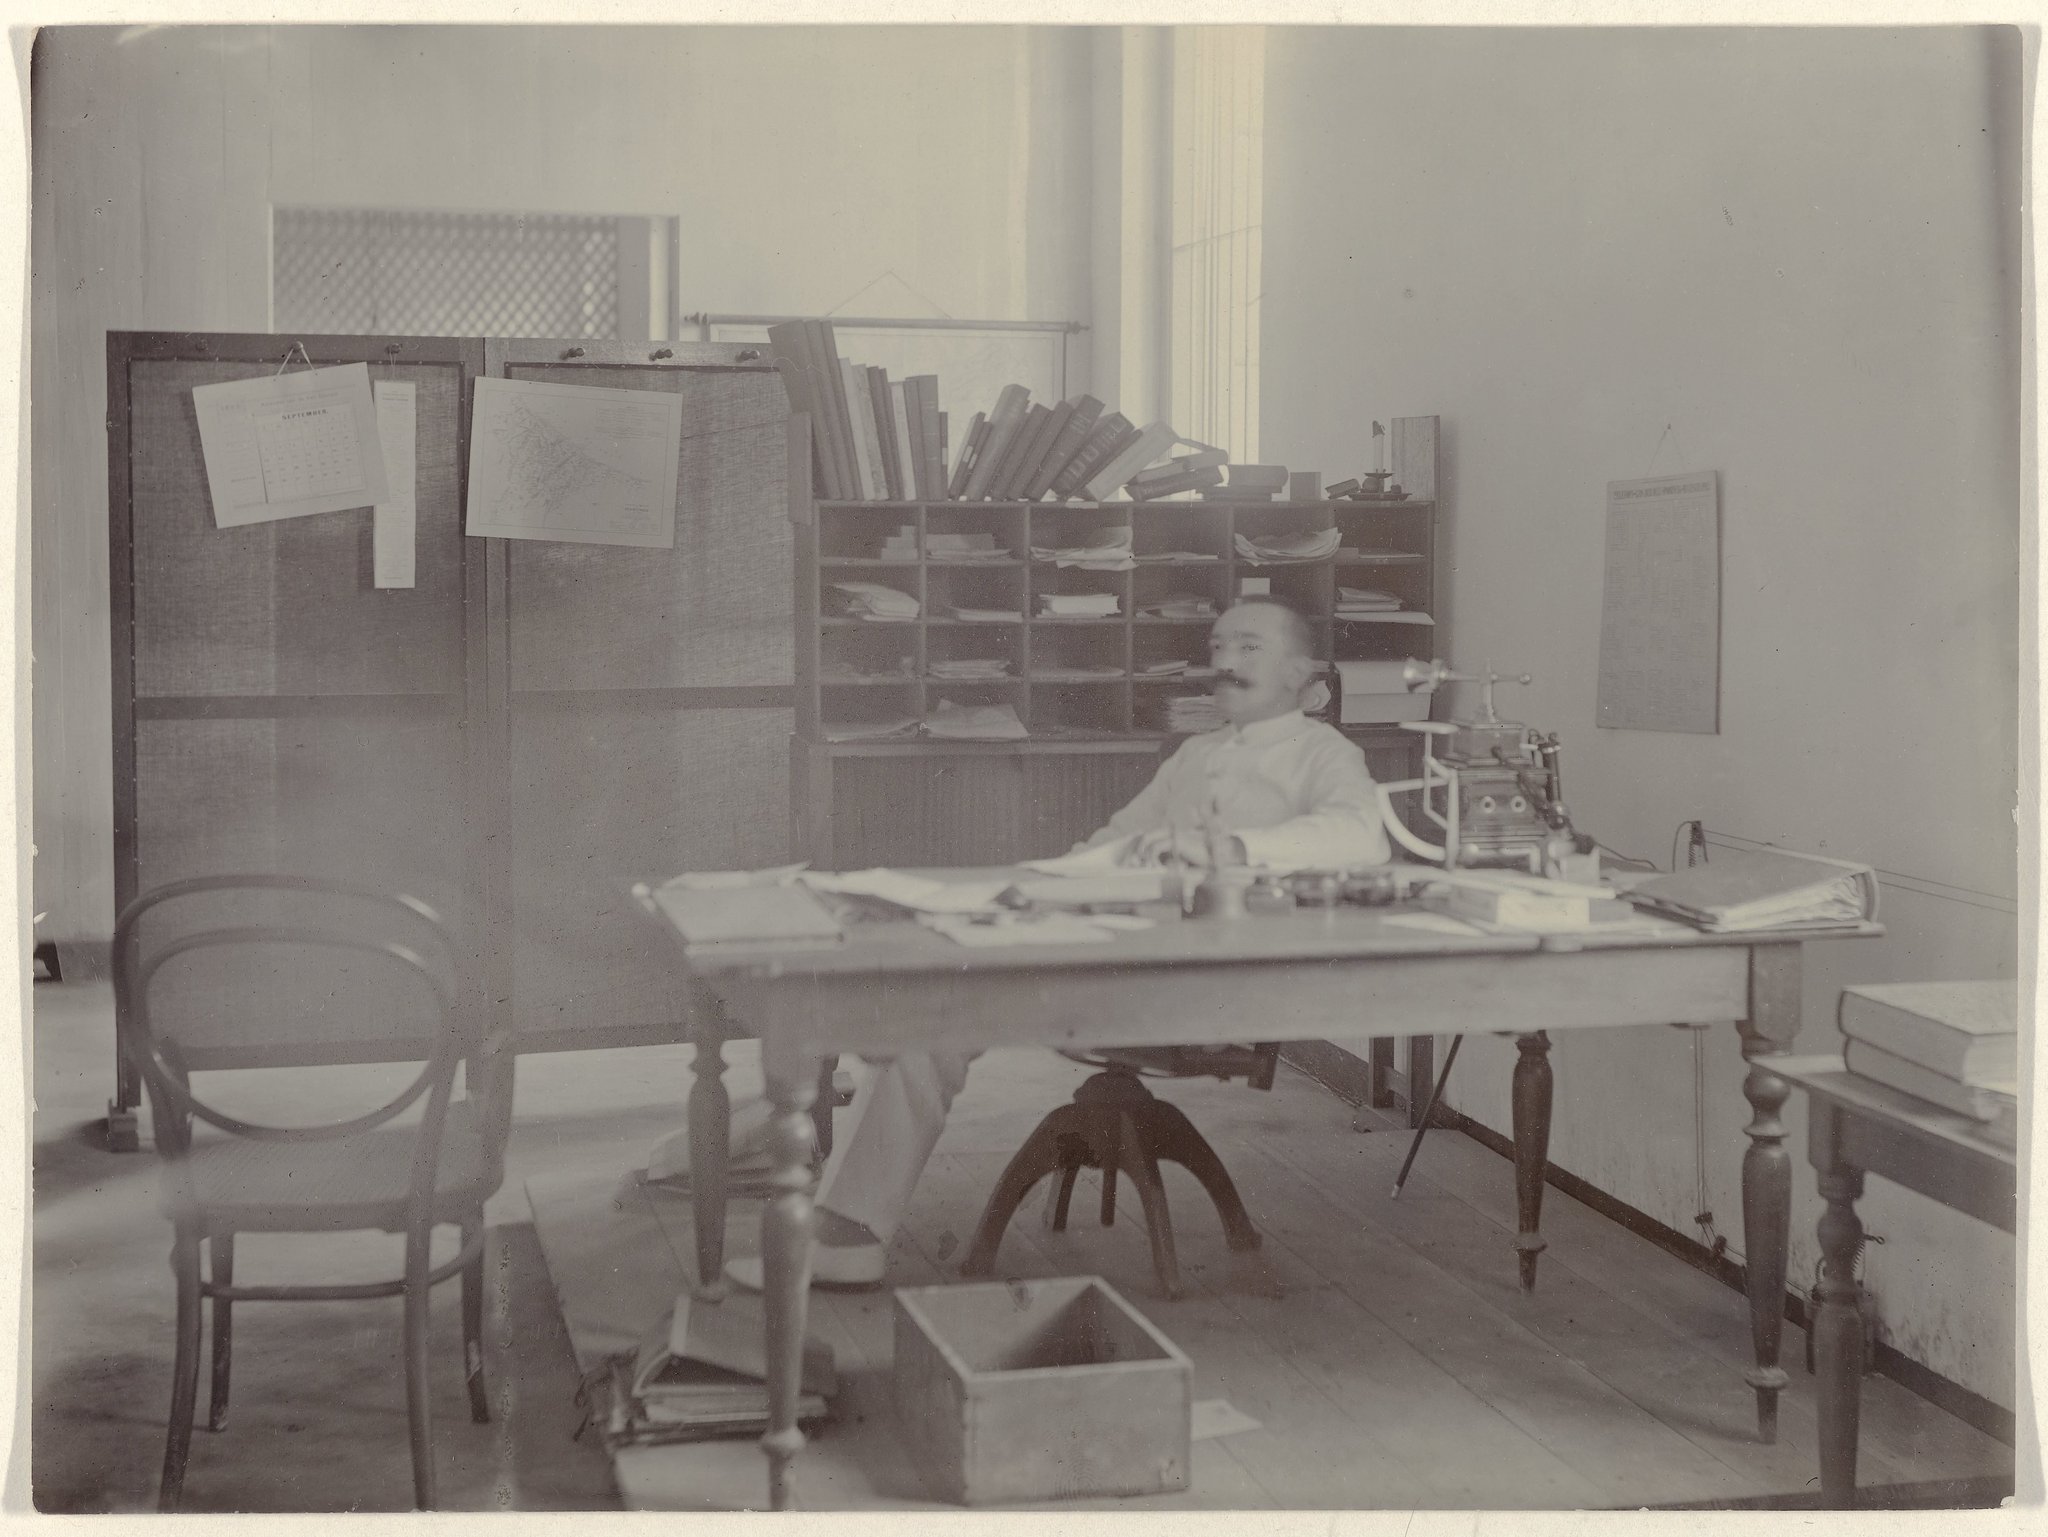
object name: photograph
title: Man achter tafel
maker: Anonymous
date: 1809-1898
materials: photographic support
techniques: collodion silver print, gelatin silver print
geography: medan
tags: dutch east indies, the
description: Een man zittend achter zijn werktafel. Waarschijnlijk een lid van de redactie van de Deli Courant te Medan. Aan een scherm hangt een kalender met de maand september van het jaar 1898. Onderdeel van een groep van 8 foto's uit september 1898 binnen de groep van 49 losse zwart-wit foto's van verschillend formaat over de uitgeverij en drukkerij van de krant Deli Courant in Medan in de periode 1885-1947.